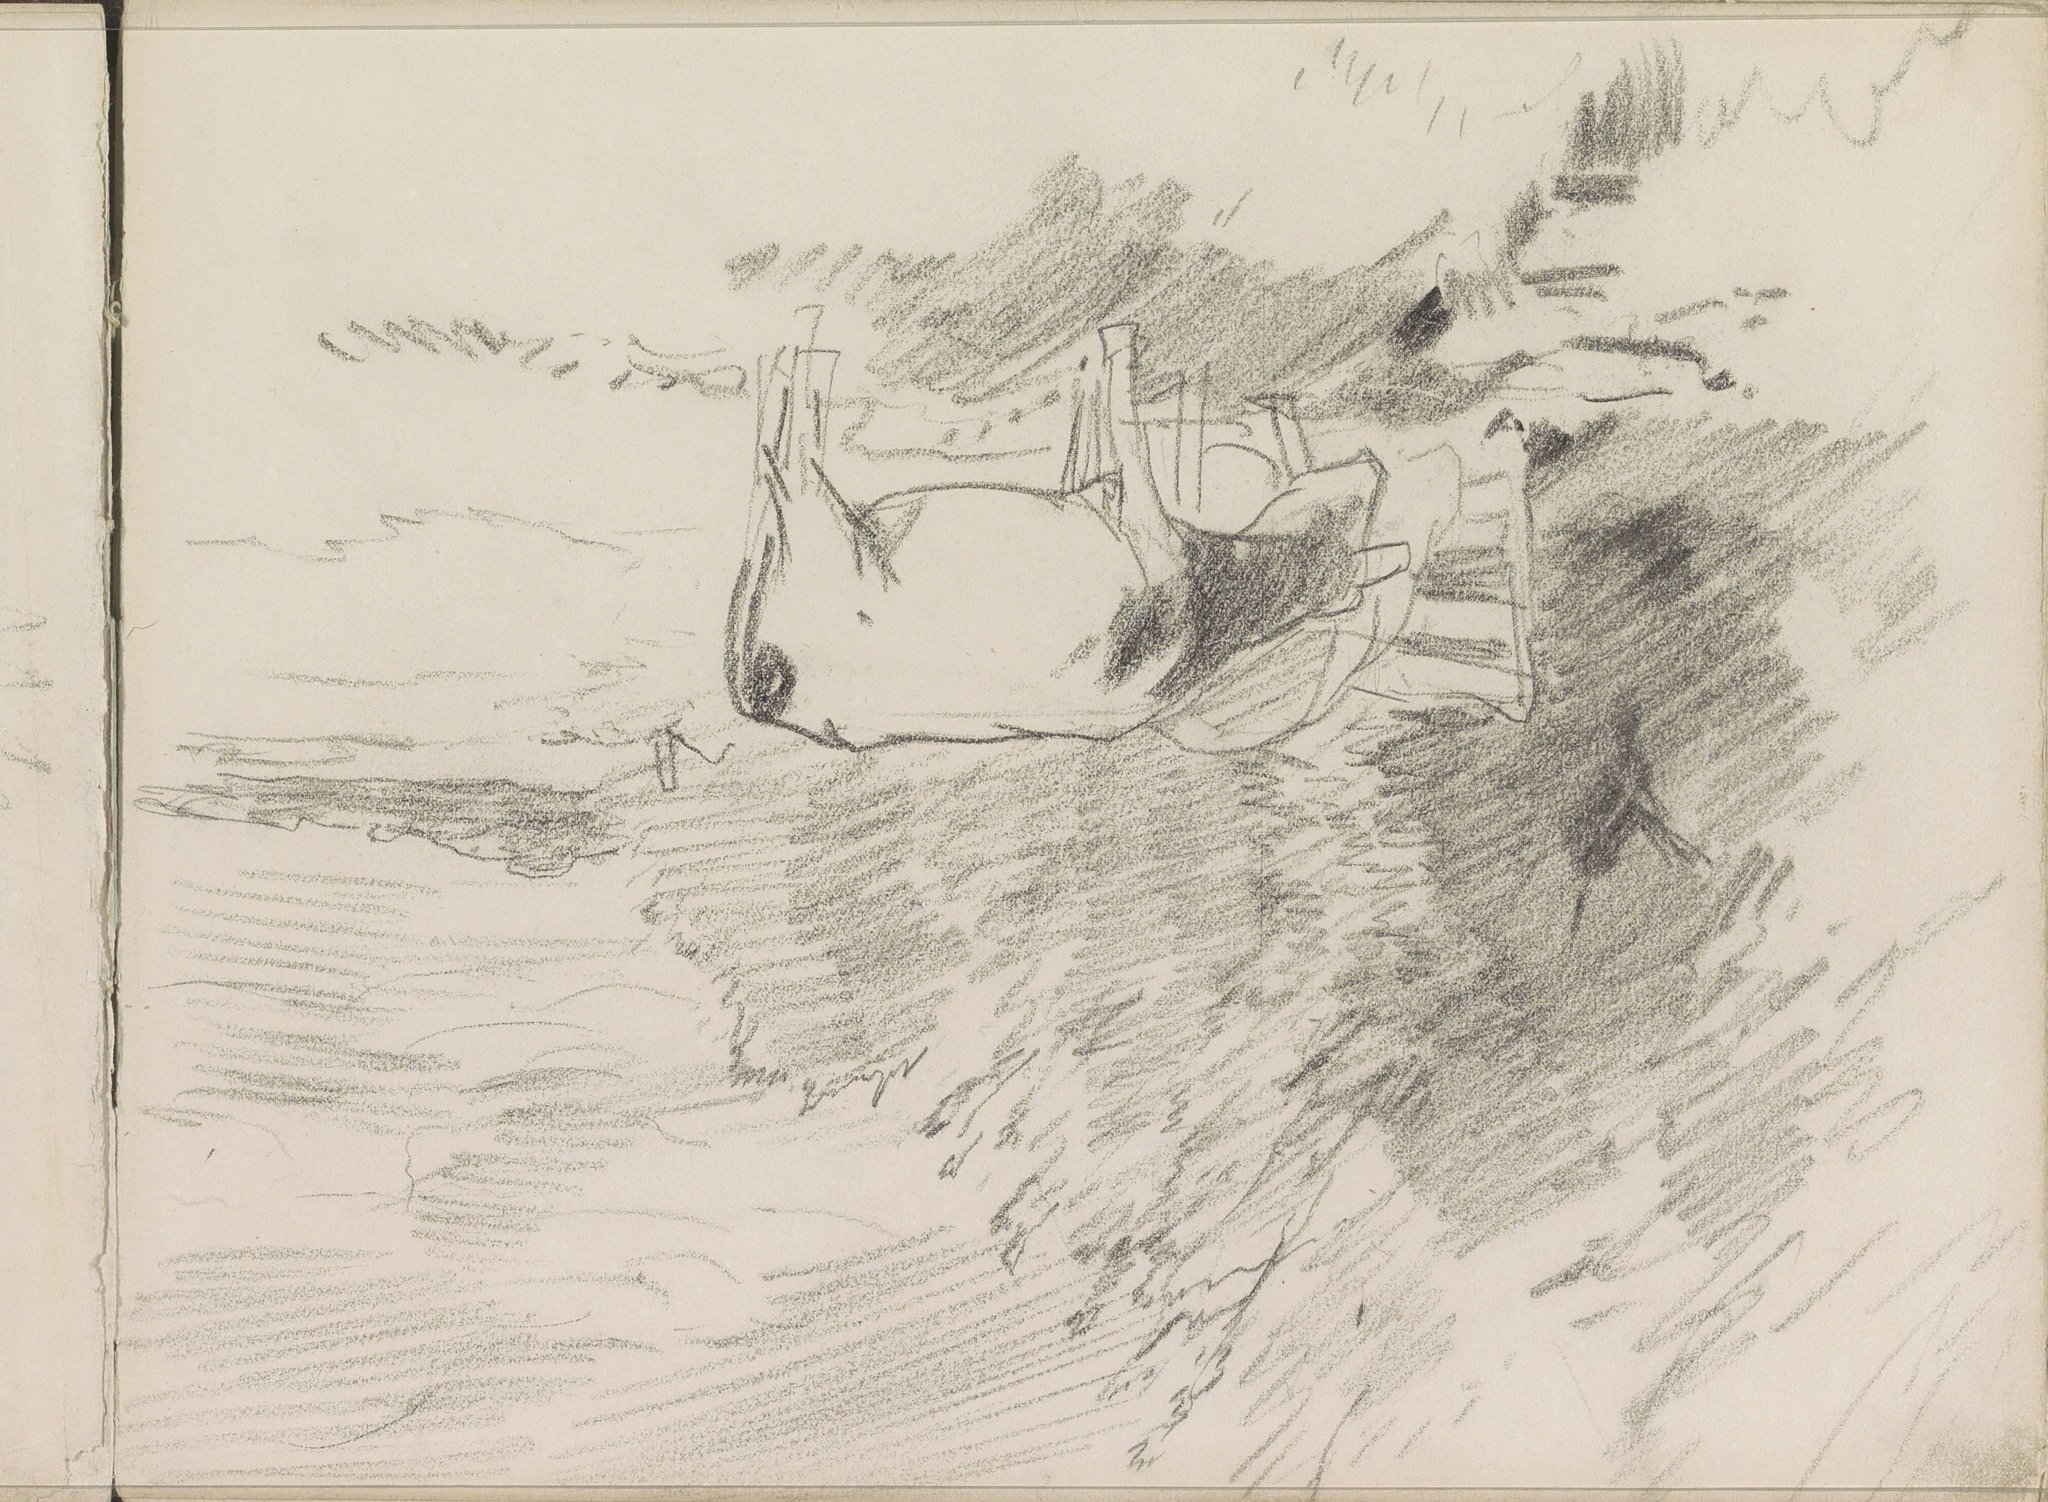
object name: sketchbook leaf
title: Twee koeien bij een hek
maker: anton mauve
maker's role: draughtsman, painter, print maker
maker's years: 1838-1888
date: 1886-1888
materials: chalk, paper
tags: cow, fence, wall, paling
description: Blad 4 recto uit een schetsboek met 27 bladen.